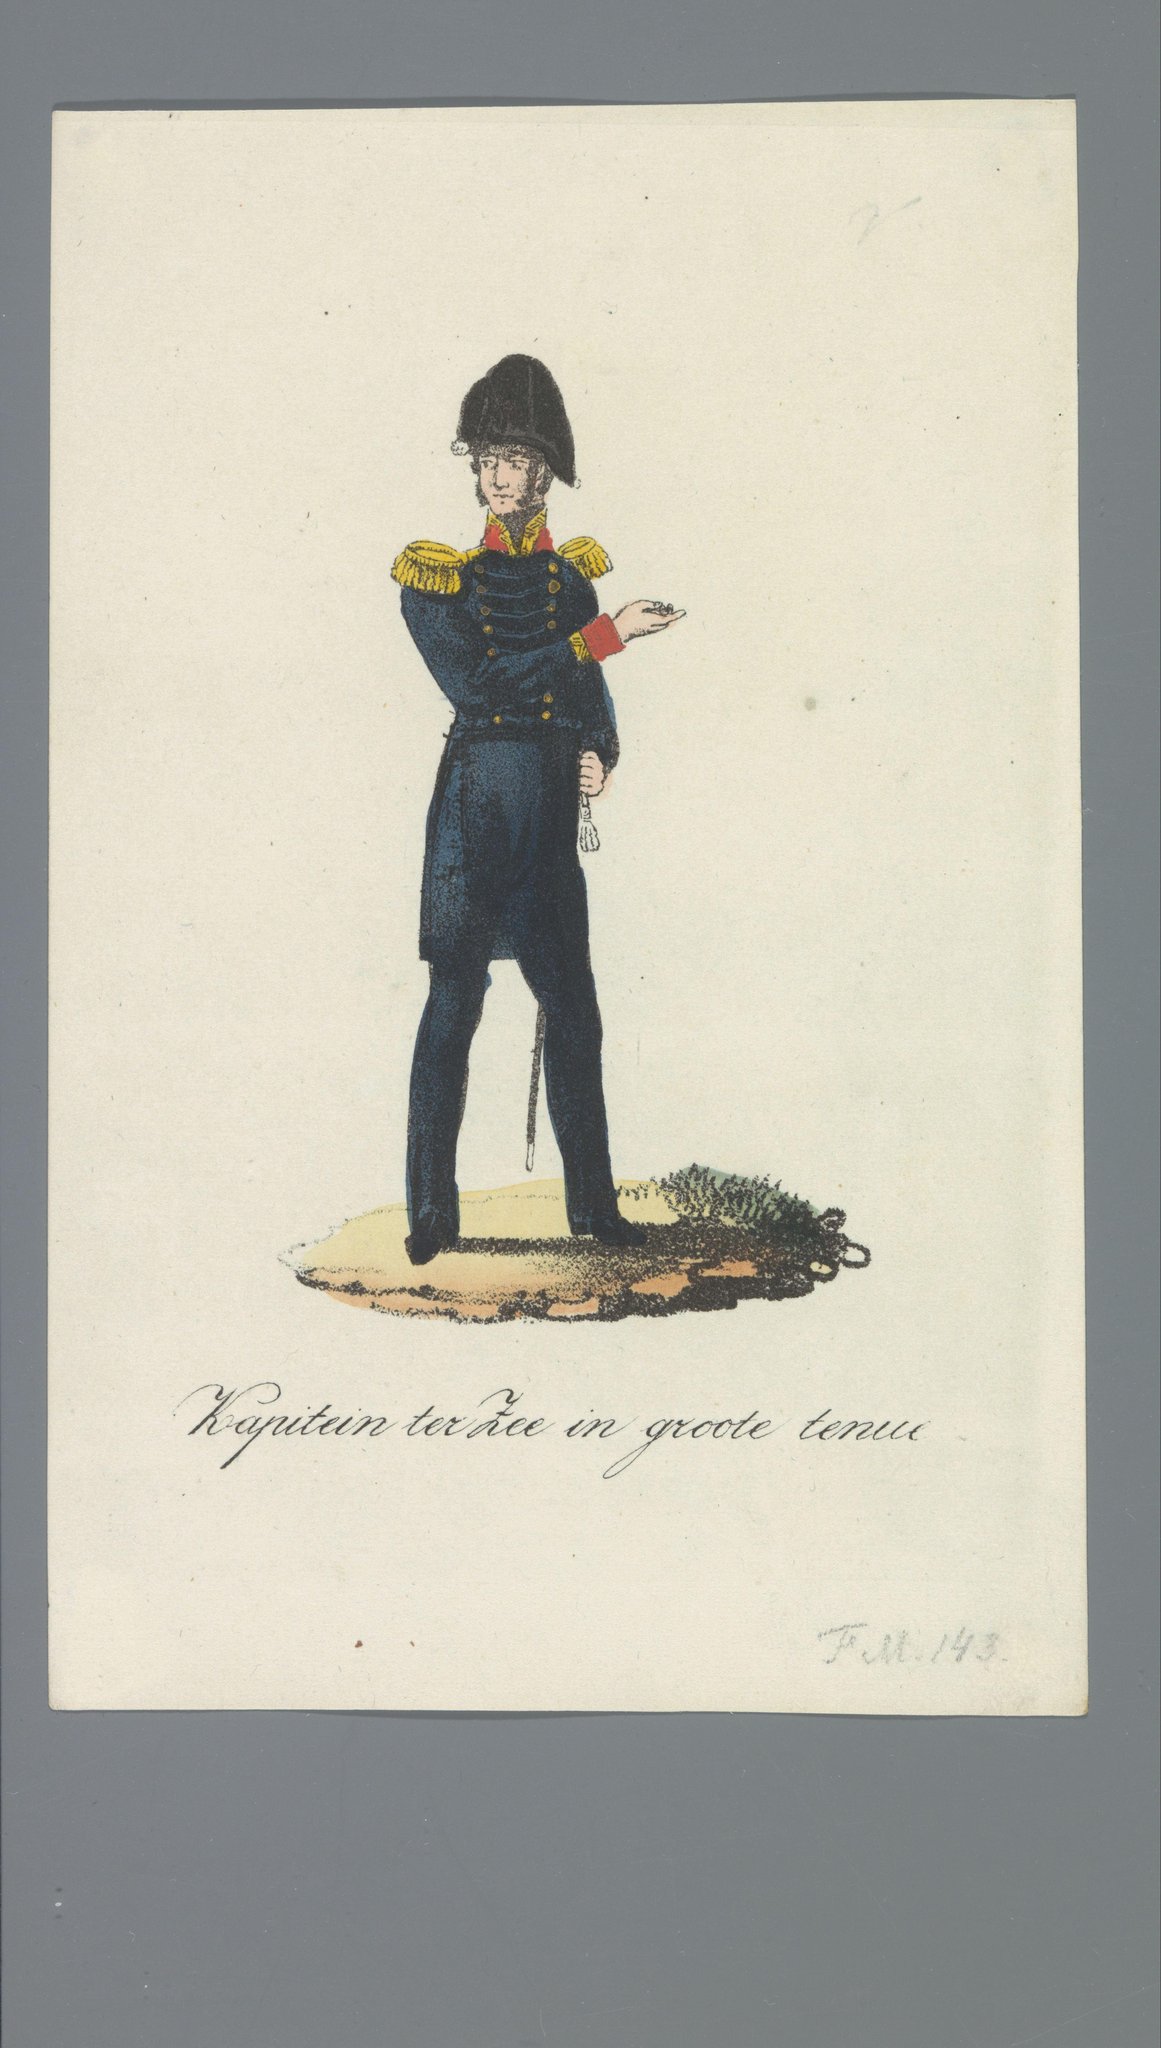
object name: print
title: Kapitein ter Zee in groote tenue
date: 1835-1850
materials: paper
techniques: hand coloring, lithograph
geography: utrecht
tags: (military) uniforms, clothes, costume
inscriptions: collector's mark: Lugt 2228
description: Een kapitein-ter-zee van de Marine in grote tenue, te voet. Onderdeel van een serie van 157 losse bladen met Nederlandse militaire uniformen in de jaren 1830-1832.